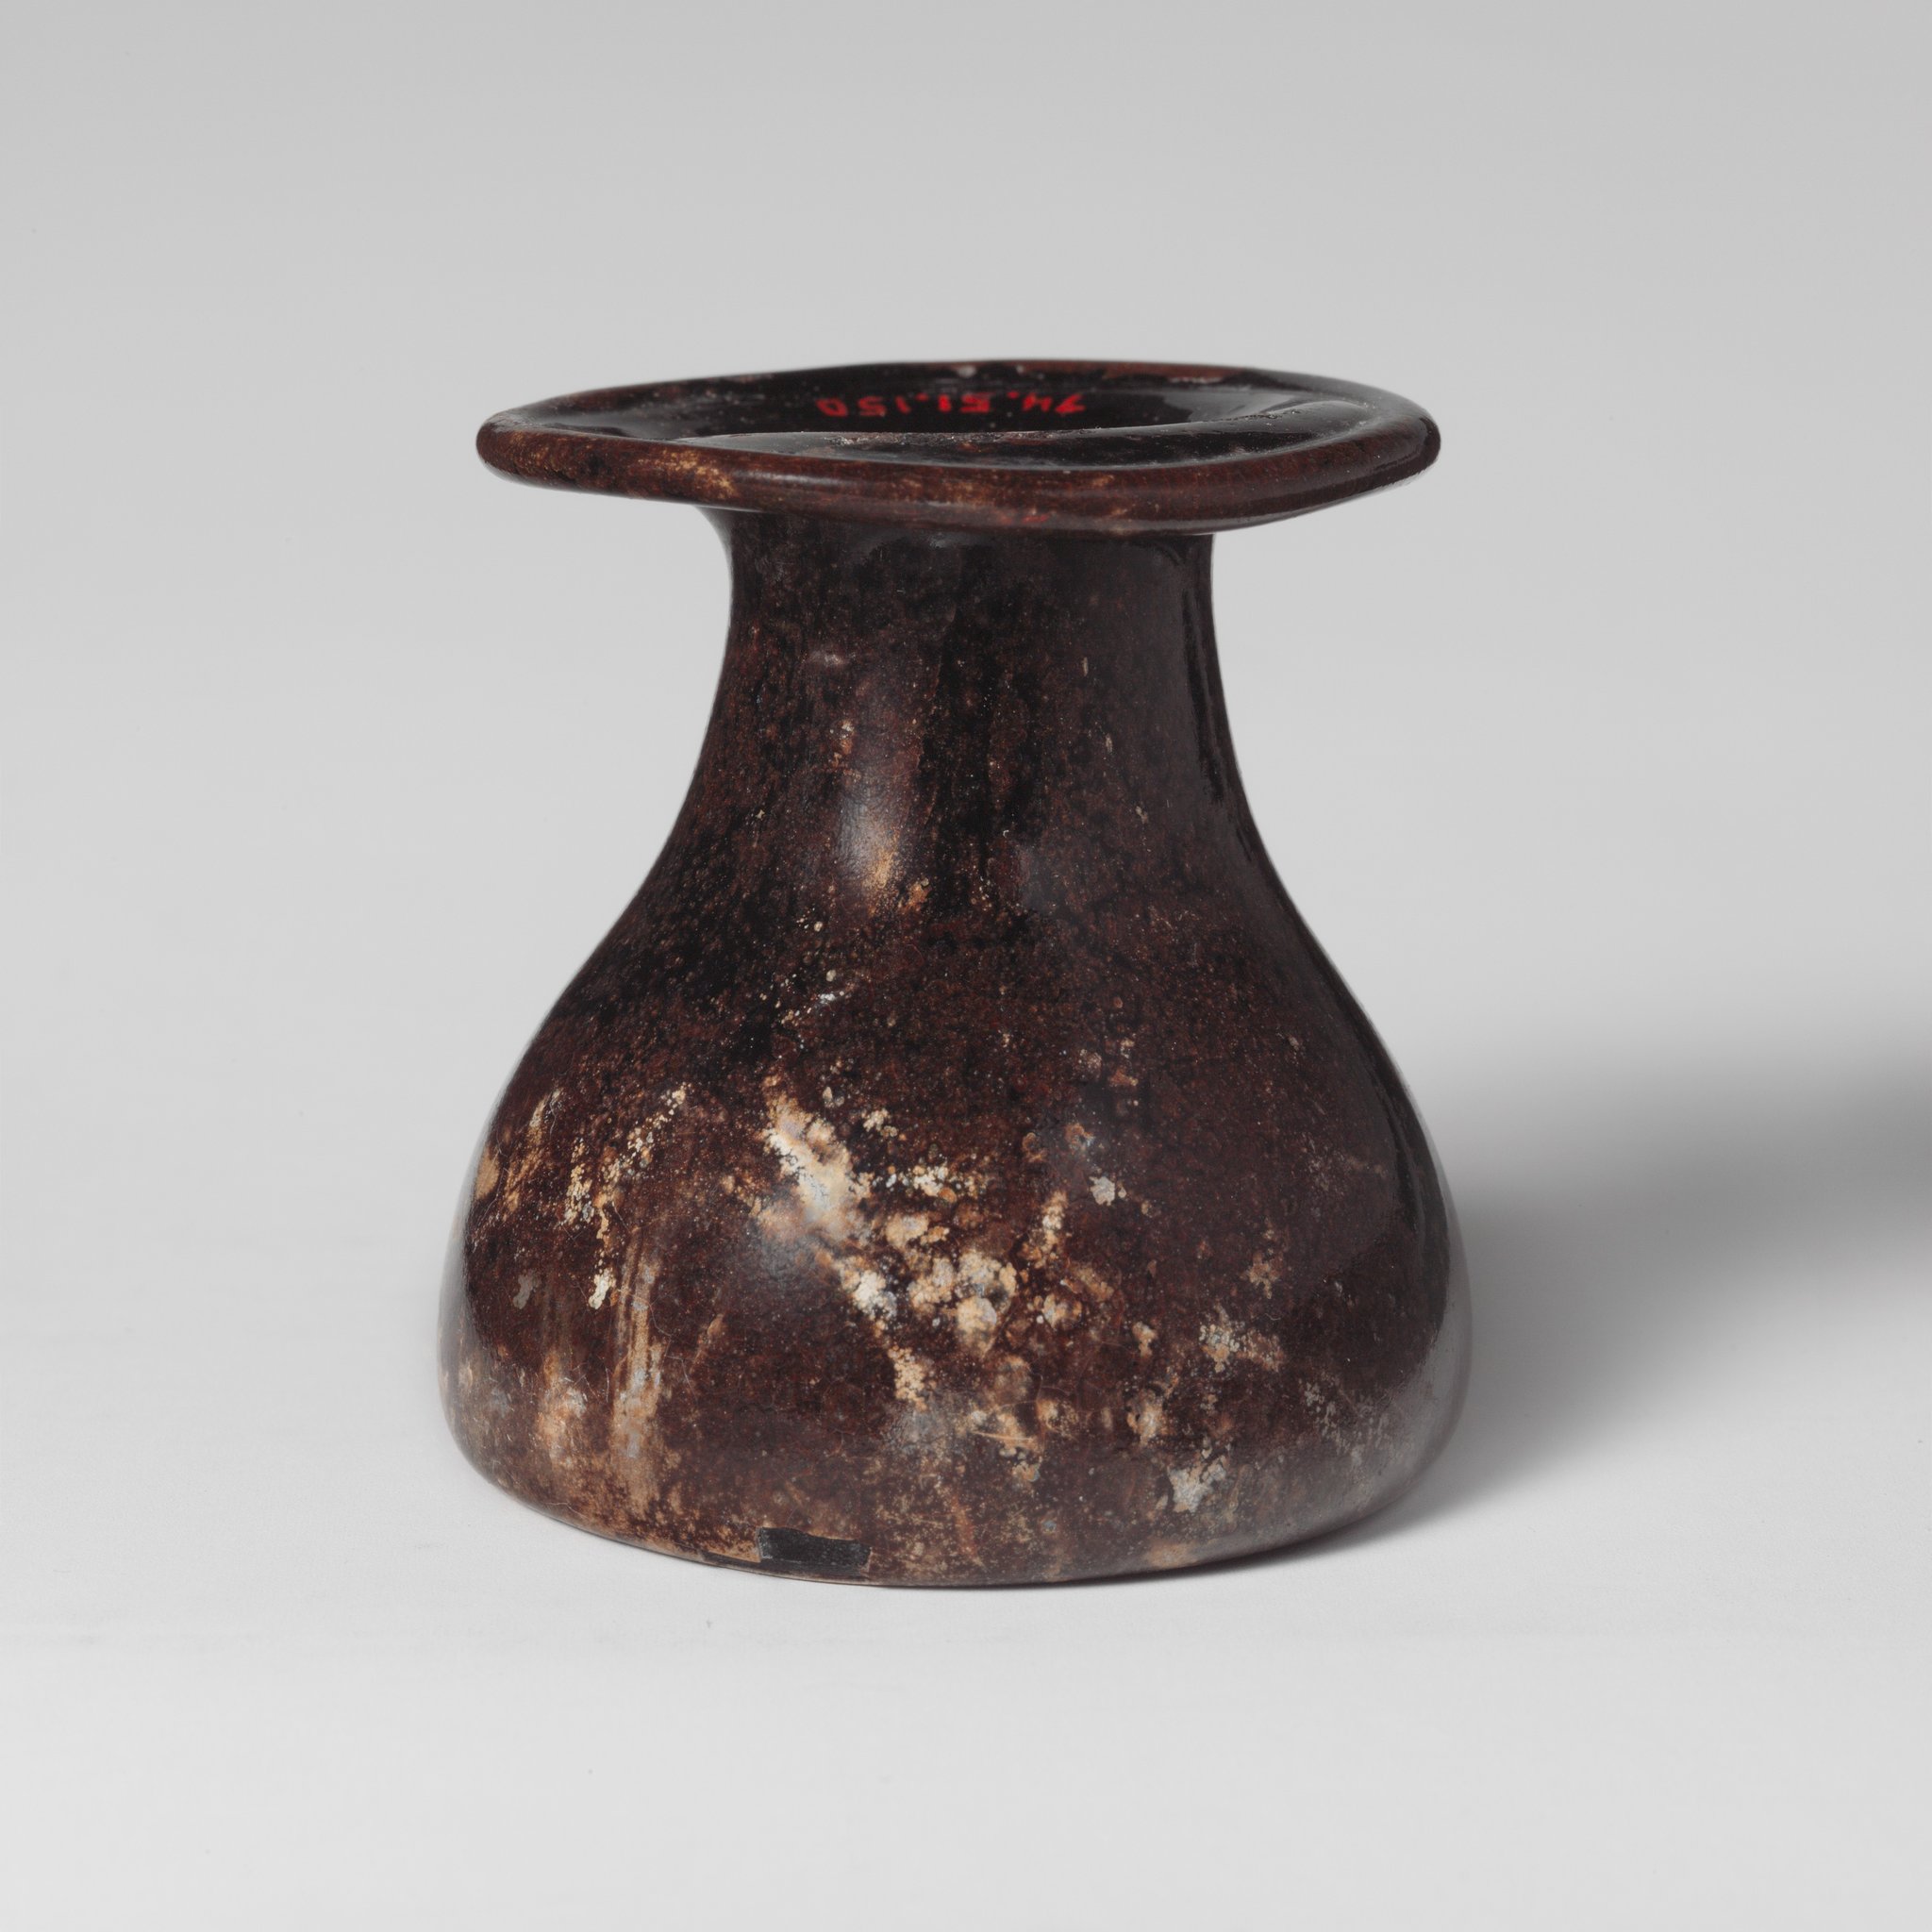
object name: trick bottle or cup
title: Glass trick bottle or cup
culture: roman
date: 101-400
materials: glass